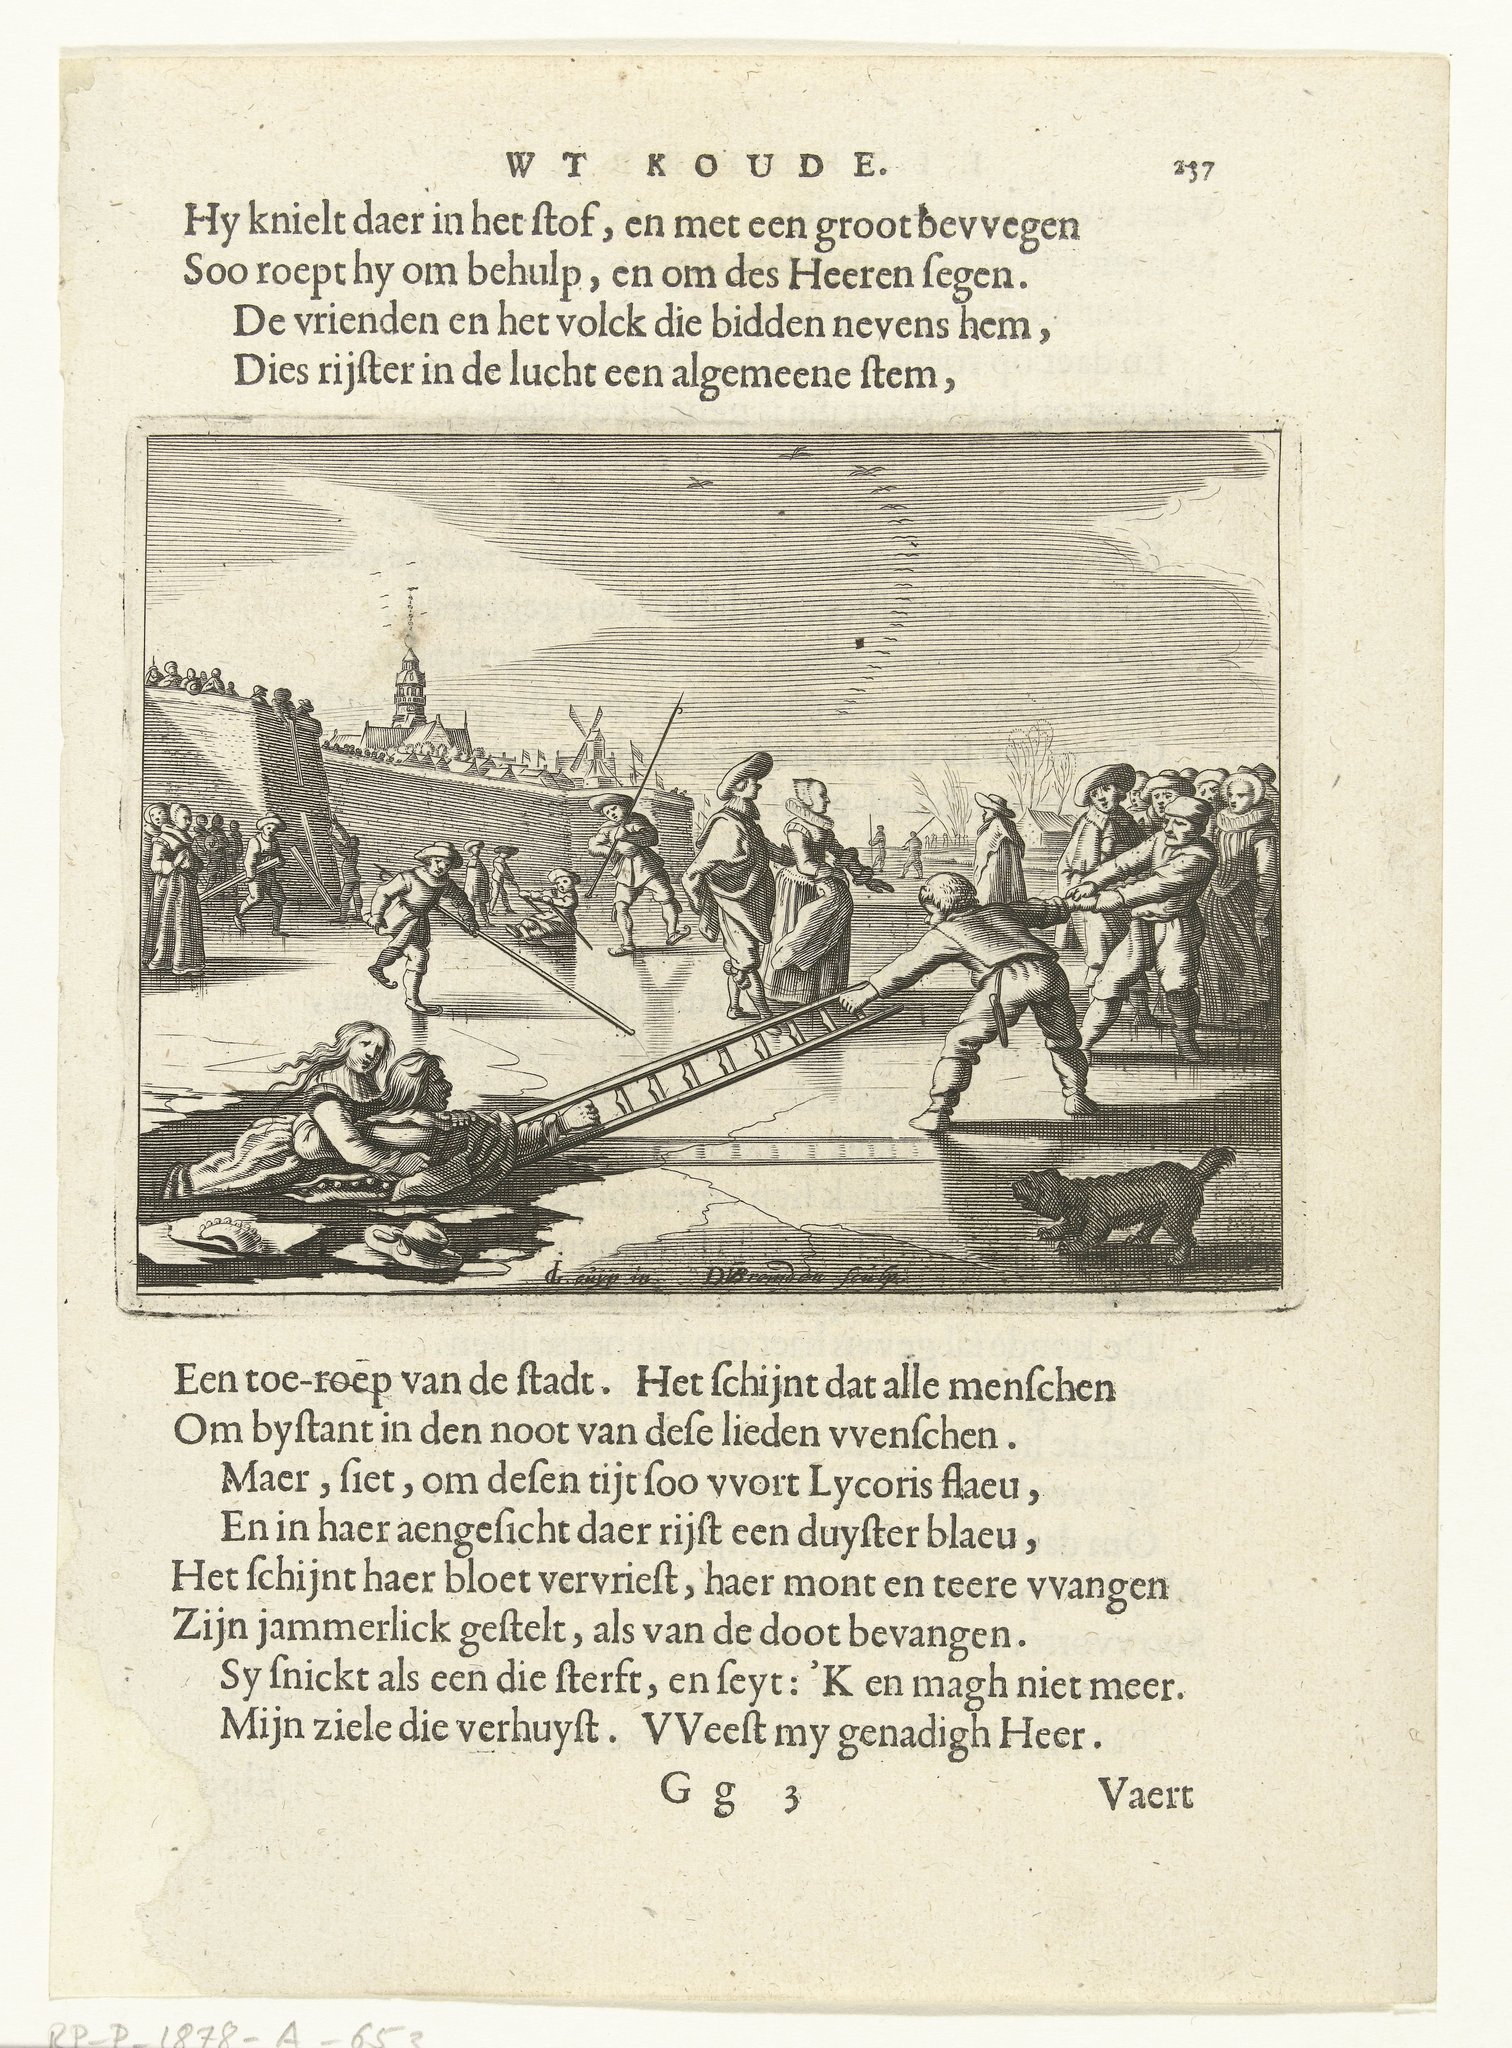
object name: print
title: Elpenor redt Lyconis uit het ijs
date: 1635-1637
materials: paper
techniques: engraving, letterpress printing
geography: amsterdam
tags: skates (winter sports) (+ accident (in sports, games, etc.))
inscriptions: collector's mark: Lugt 2228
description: Lycoris zakt door het ijs. Elpenor haar geliefde probeert haar te redden en springt ook in het water. Een jongen brengt een ladder en probeert het stel uit het water te trekken. Bladzijde uit een boek met tekst op recto en verso.